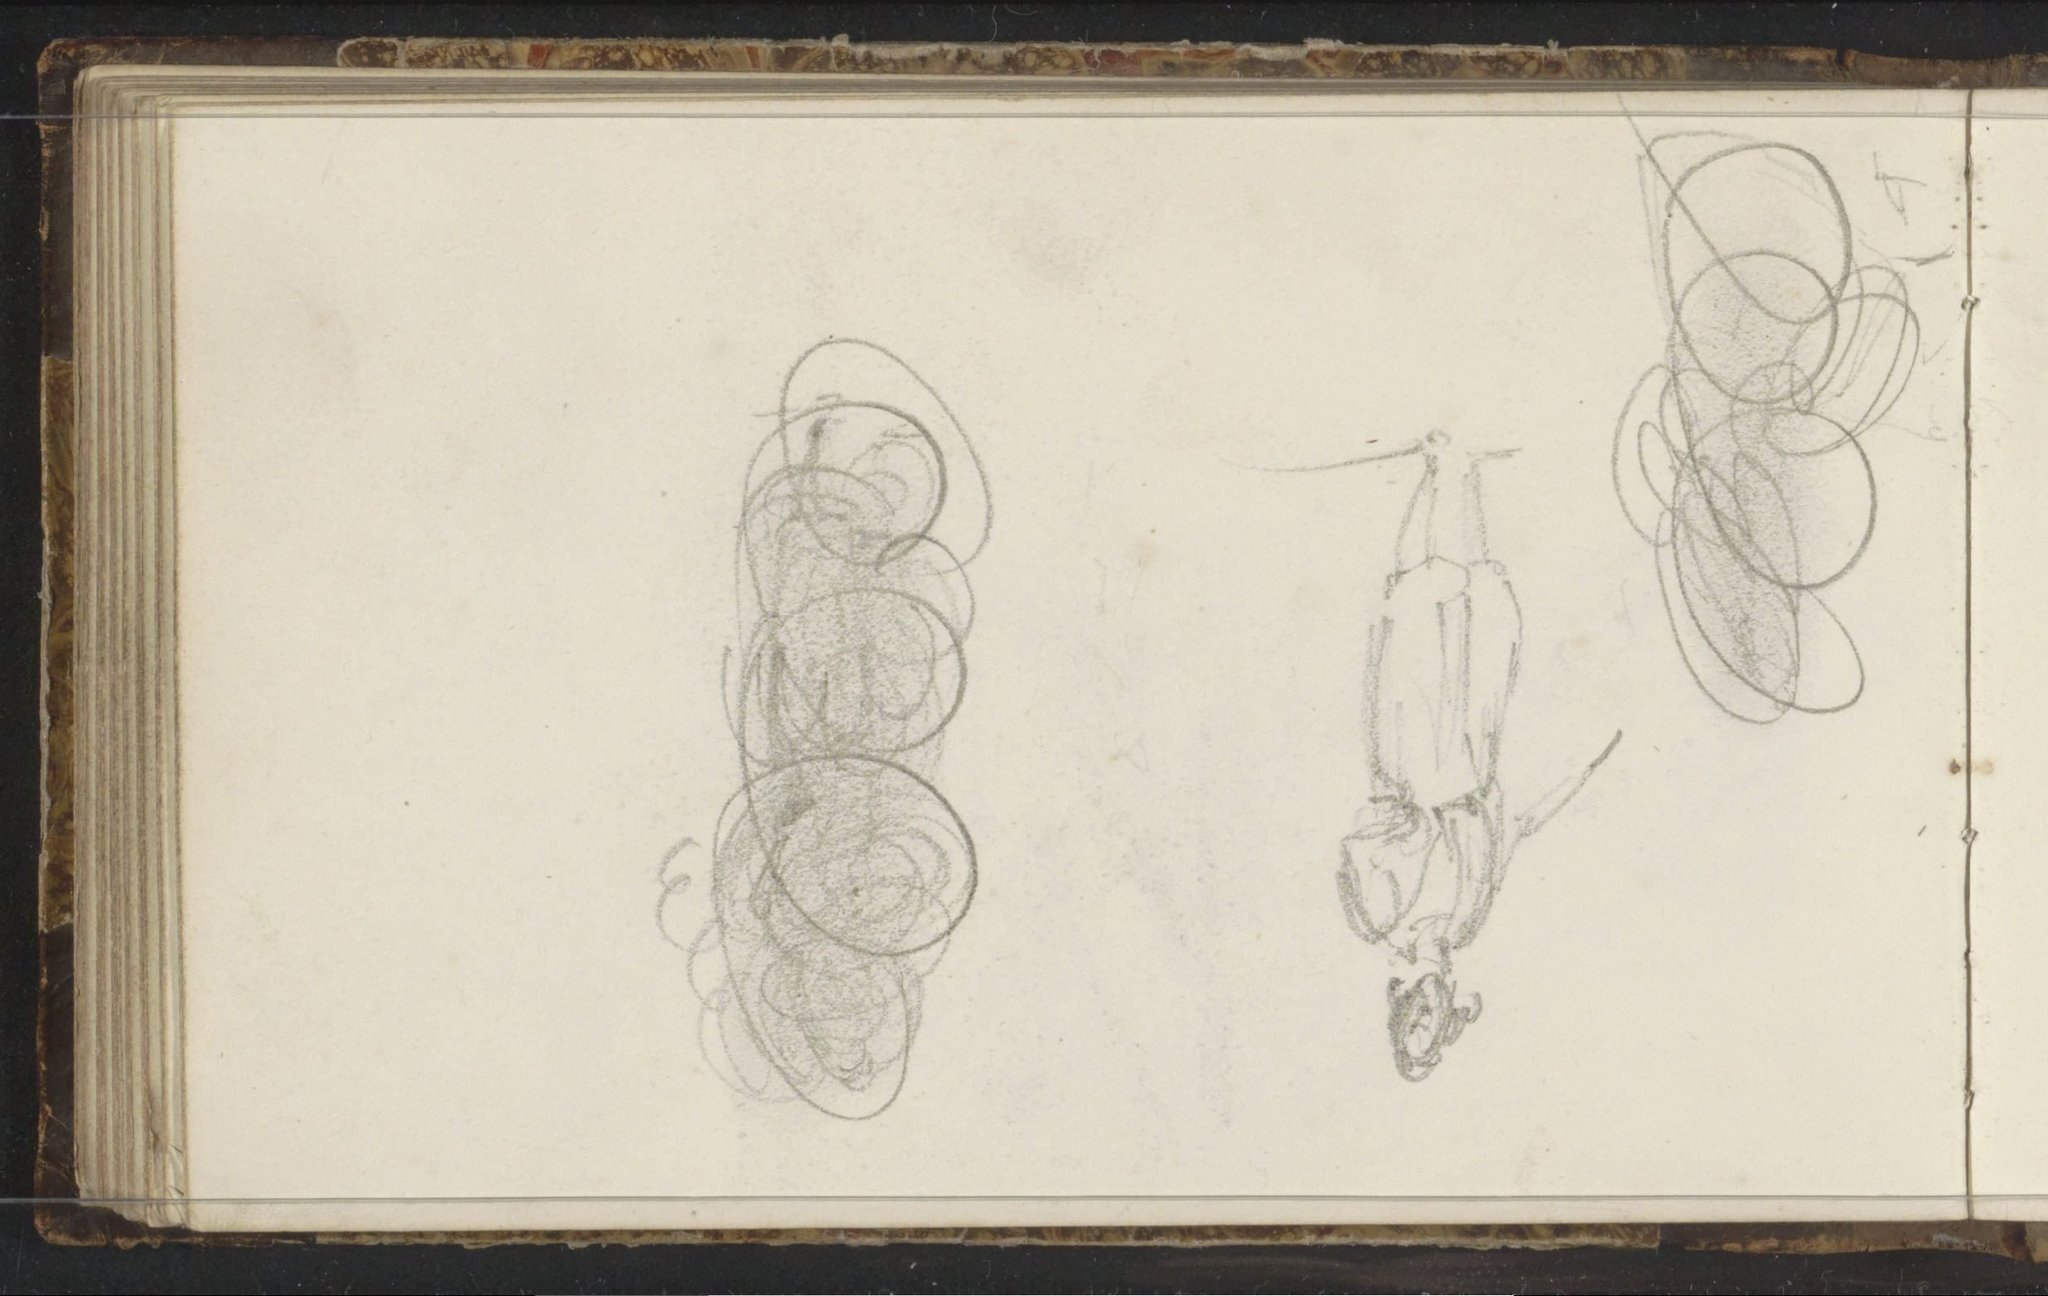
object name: sketchbook leaf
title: Staande figuur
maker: willem hendrik schmidt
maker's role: draughtsman, painter, print maker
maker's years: 1809-1849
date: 1819-1849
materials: paper, pencil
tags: standing figure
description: Tevens twee studies. Blad 47 verso uit een schetsboek met 60 bladen.